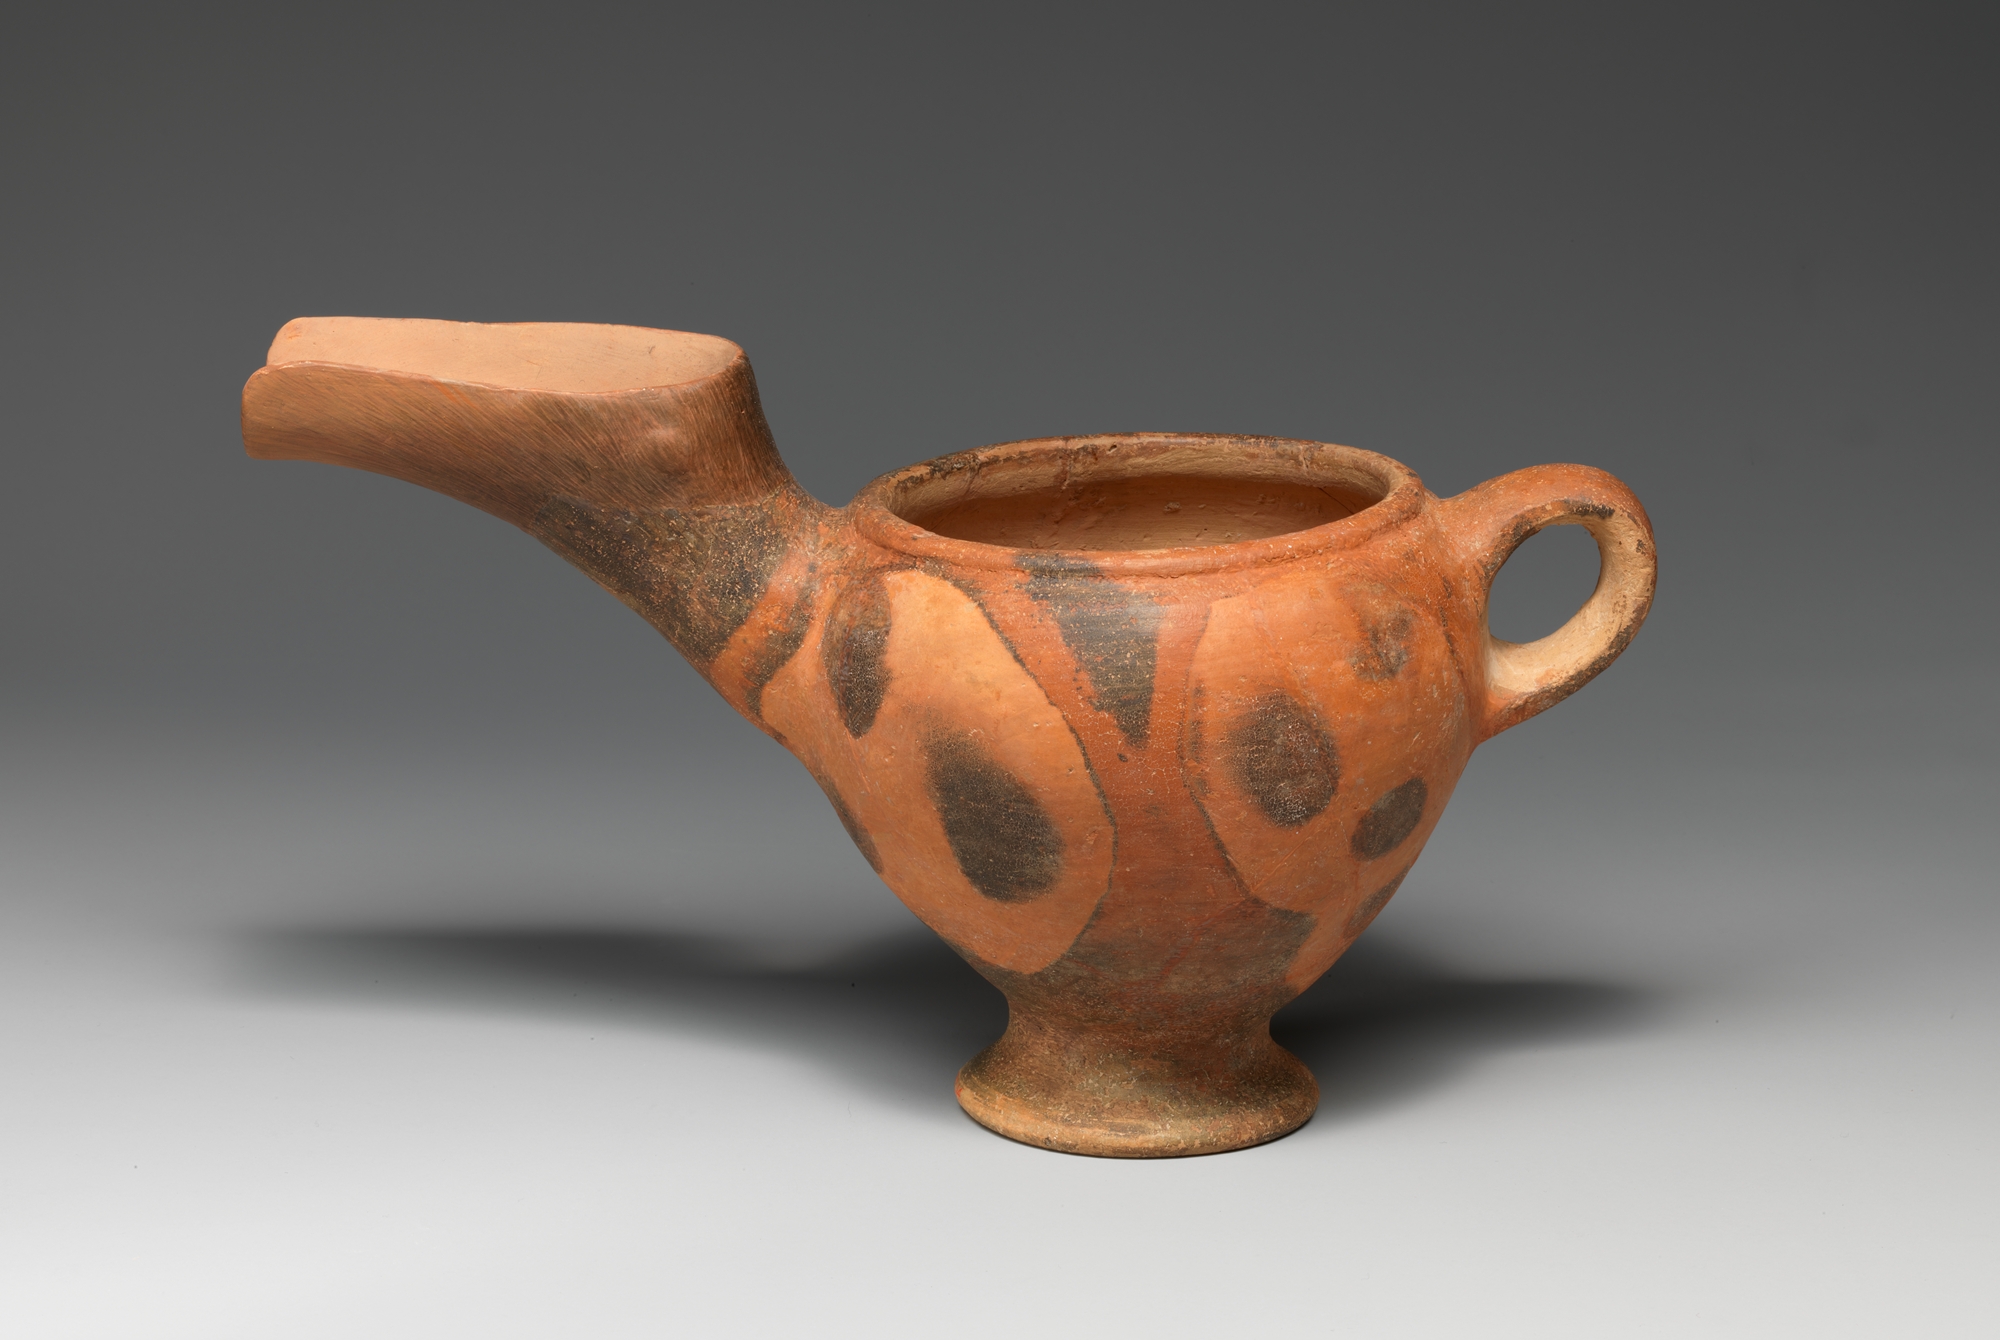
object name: jug, beak spouted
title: Terracotta beak-spouted jar, Vasiliki ware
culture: minoan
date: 2600-2200 BCE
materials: terracotta